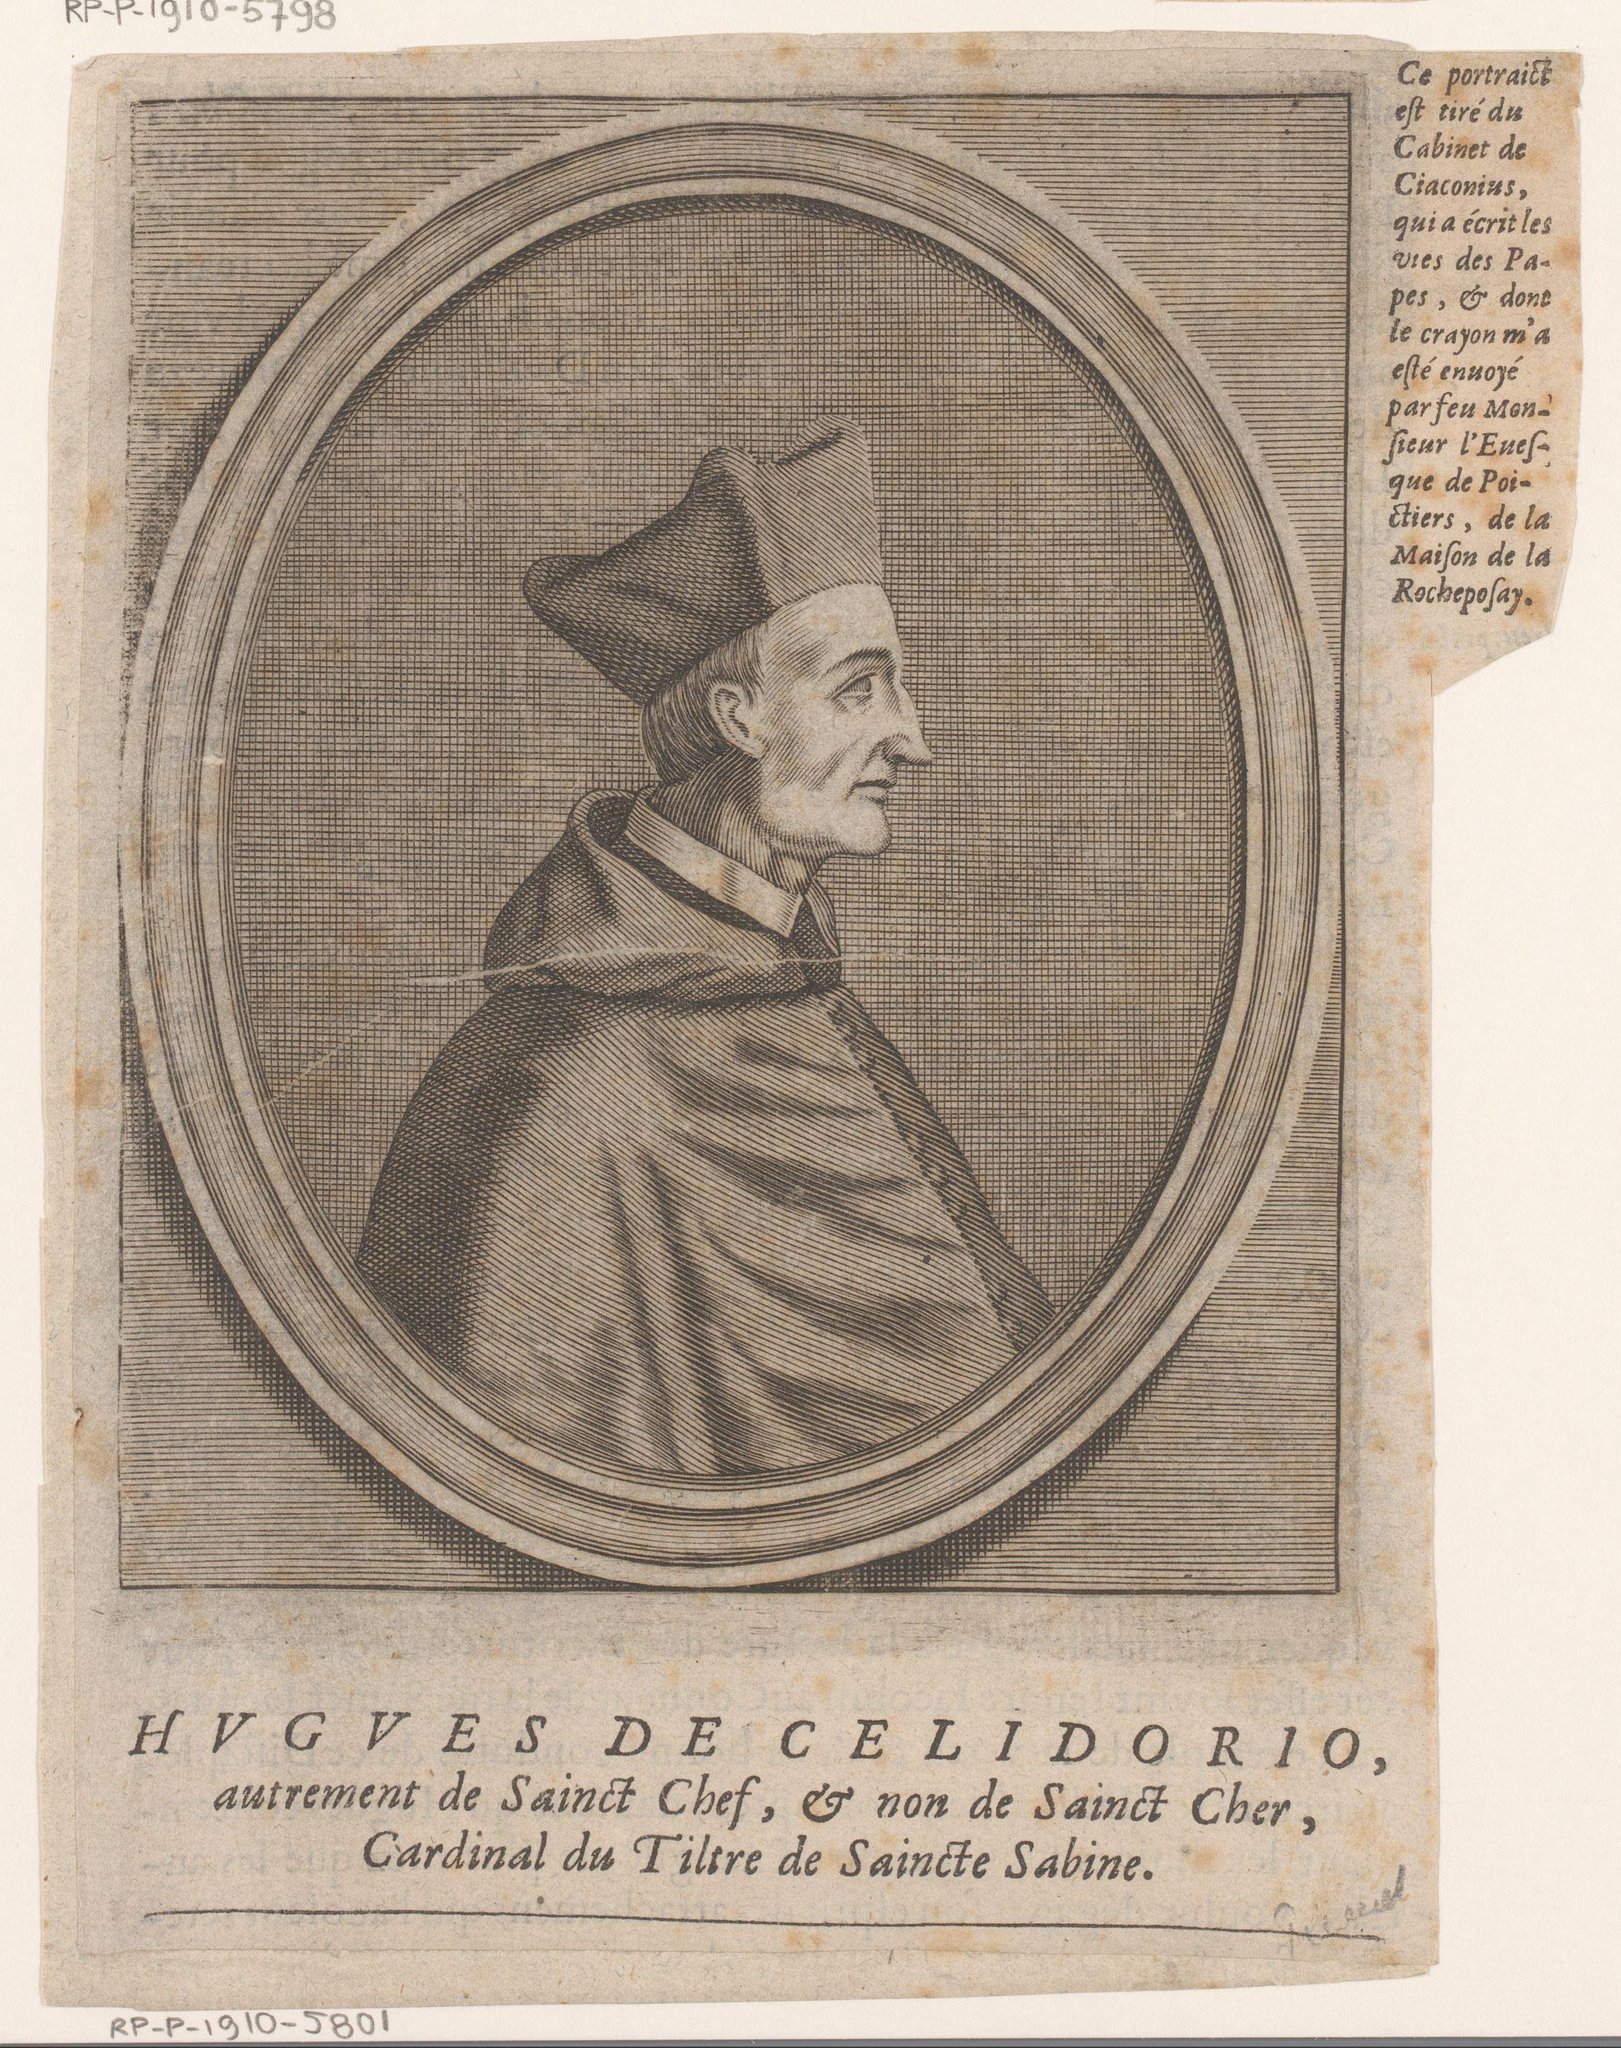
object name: print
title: Portret van Hugo van Saint-Cher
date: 1660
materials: paper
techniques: engraving, etching, letterpress printing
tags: cardinal, historical persons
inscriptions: collector's mark: Lugt 2228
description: Prent uit: Du Chesne, François. Histoire de tous les cardinaux françois de naissance, ou qui ont esté promeus au cardinalat. Parijs: François Du Chesne, 1660.